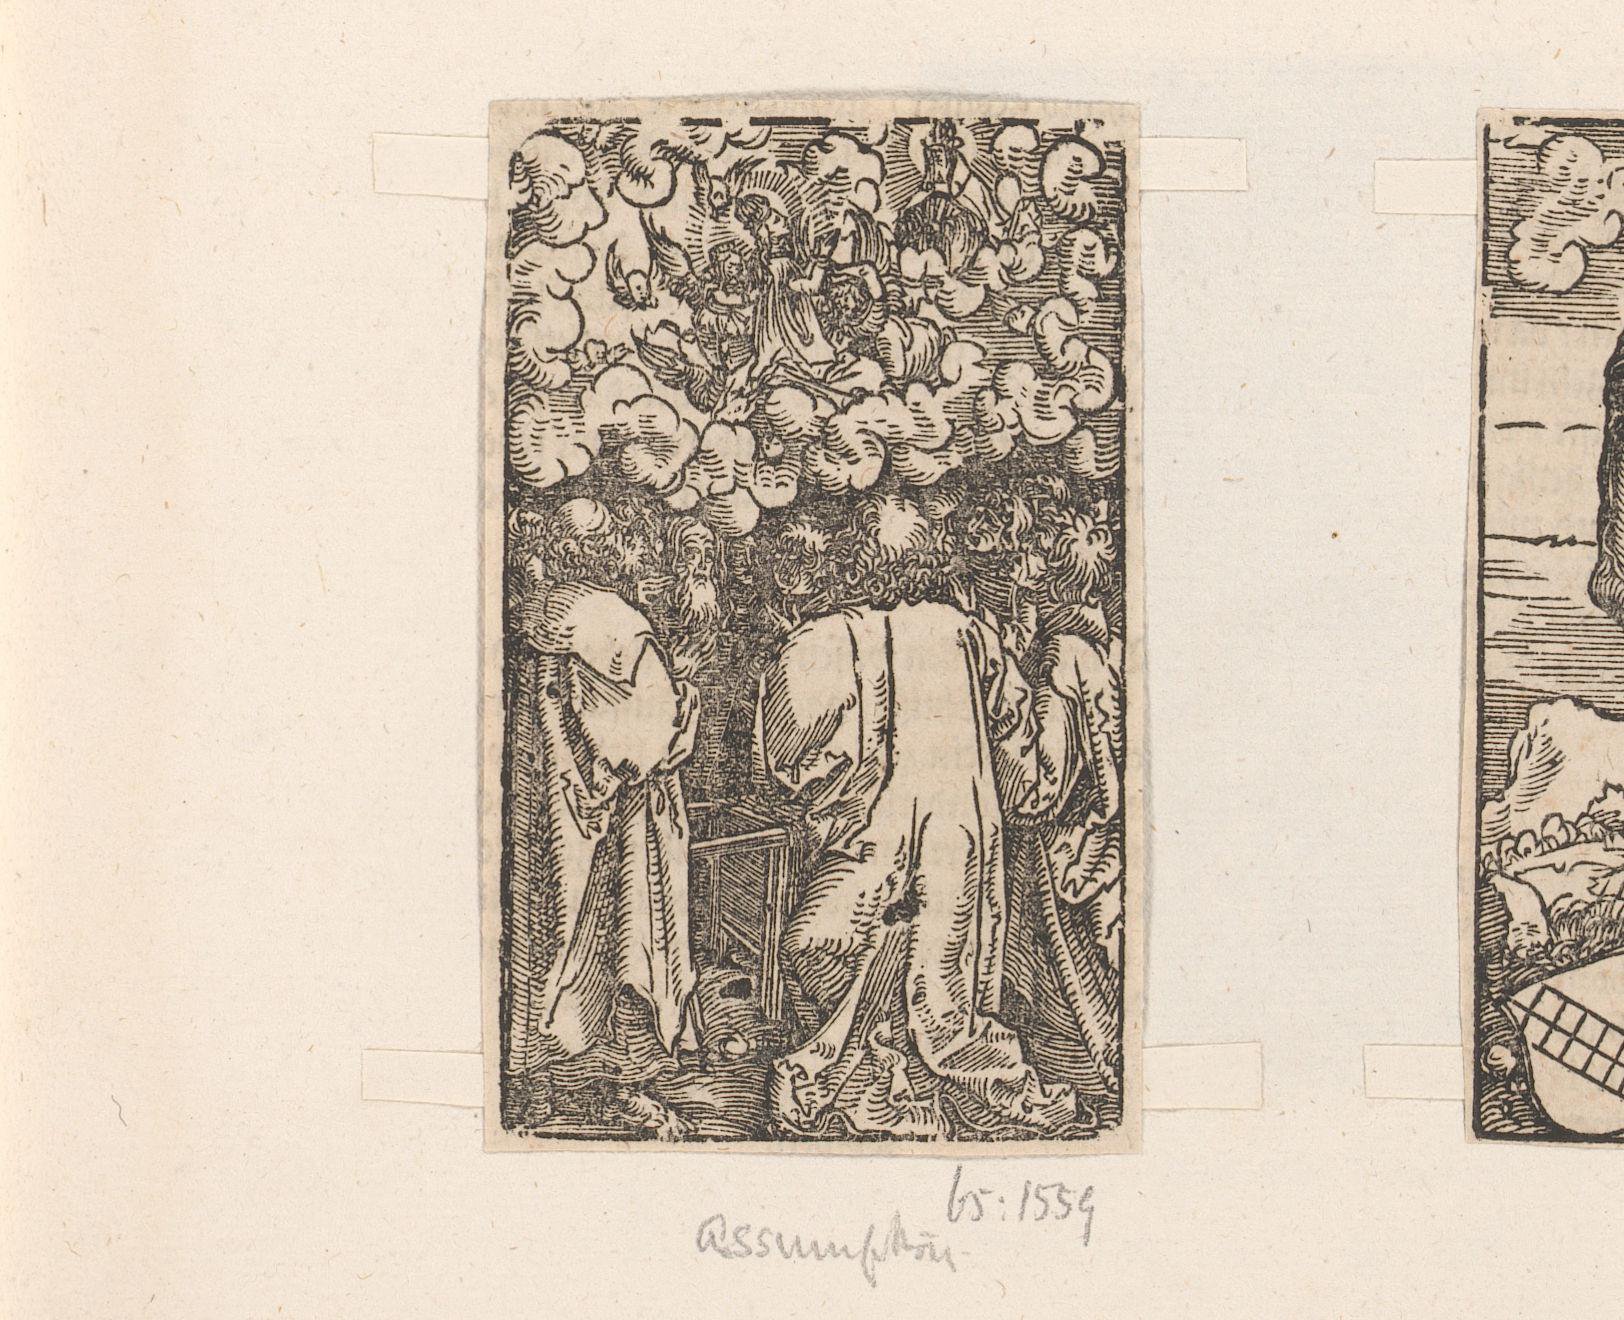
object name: print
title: Hemelvaart van Maria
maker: Anonymous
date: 1500-1536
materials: paper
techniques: letterpress printing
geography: germany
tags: assumption of mary combined with her coronation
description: De hemelvaart van Maria. De apostelen zijn achtergebleven en kijken omhoog. Maria wordt omringd door engelen en is gekroond. Ze wordt ontvangen door God de Vader. Prent maakt deel uit van een album.